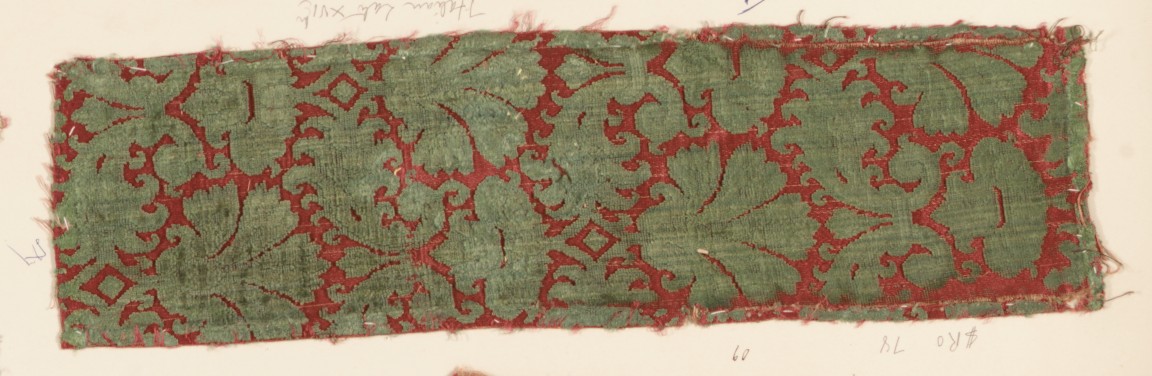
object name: fragment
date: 1567-1600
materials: silk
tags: flowers